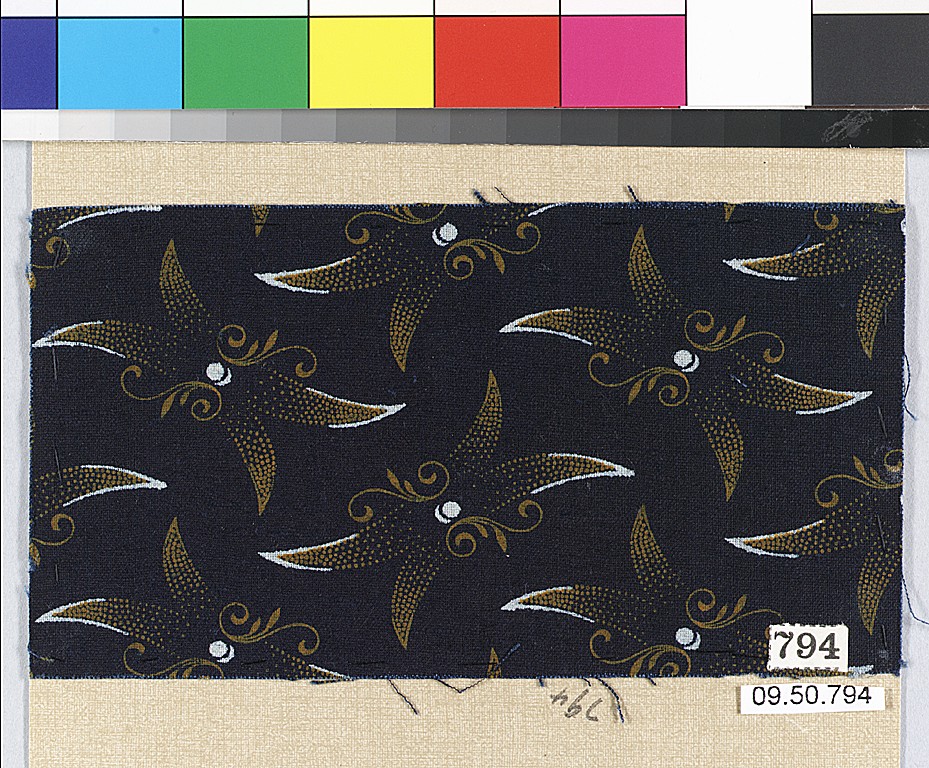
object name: piece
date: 1801-1900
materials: cotton